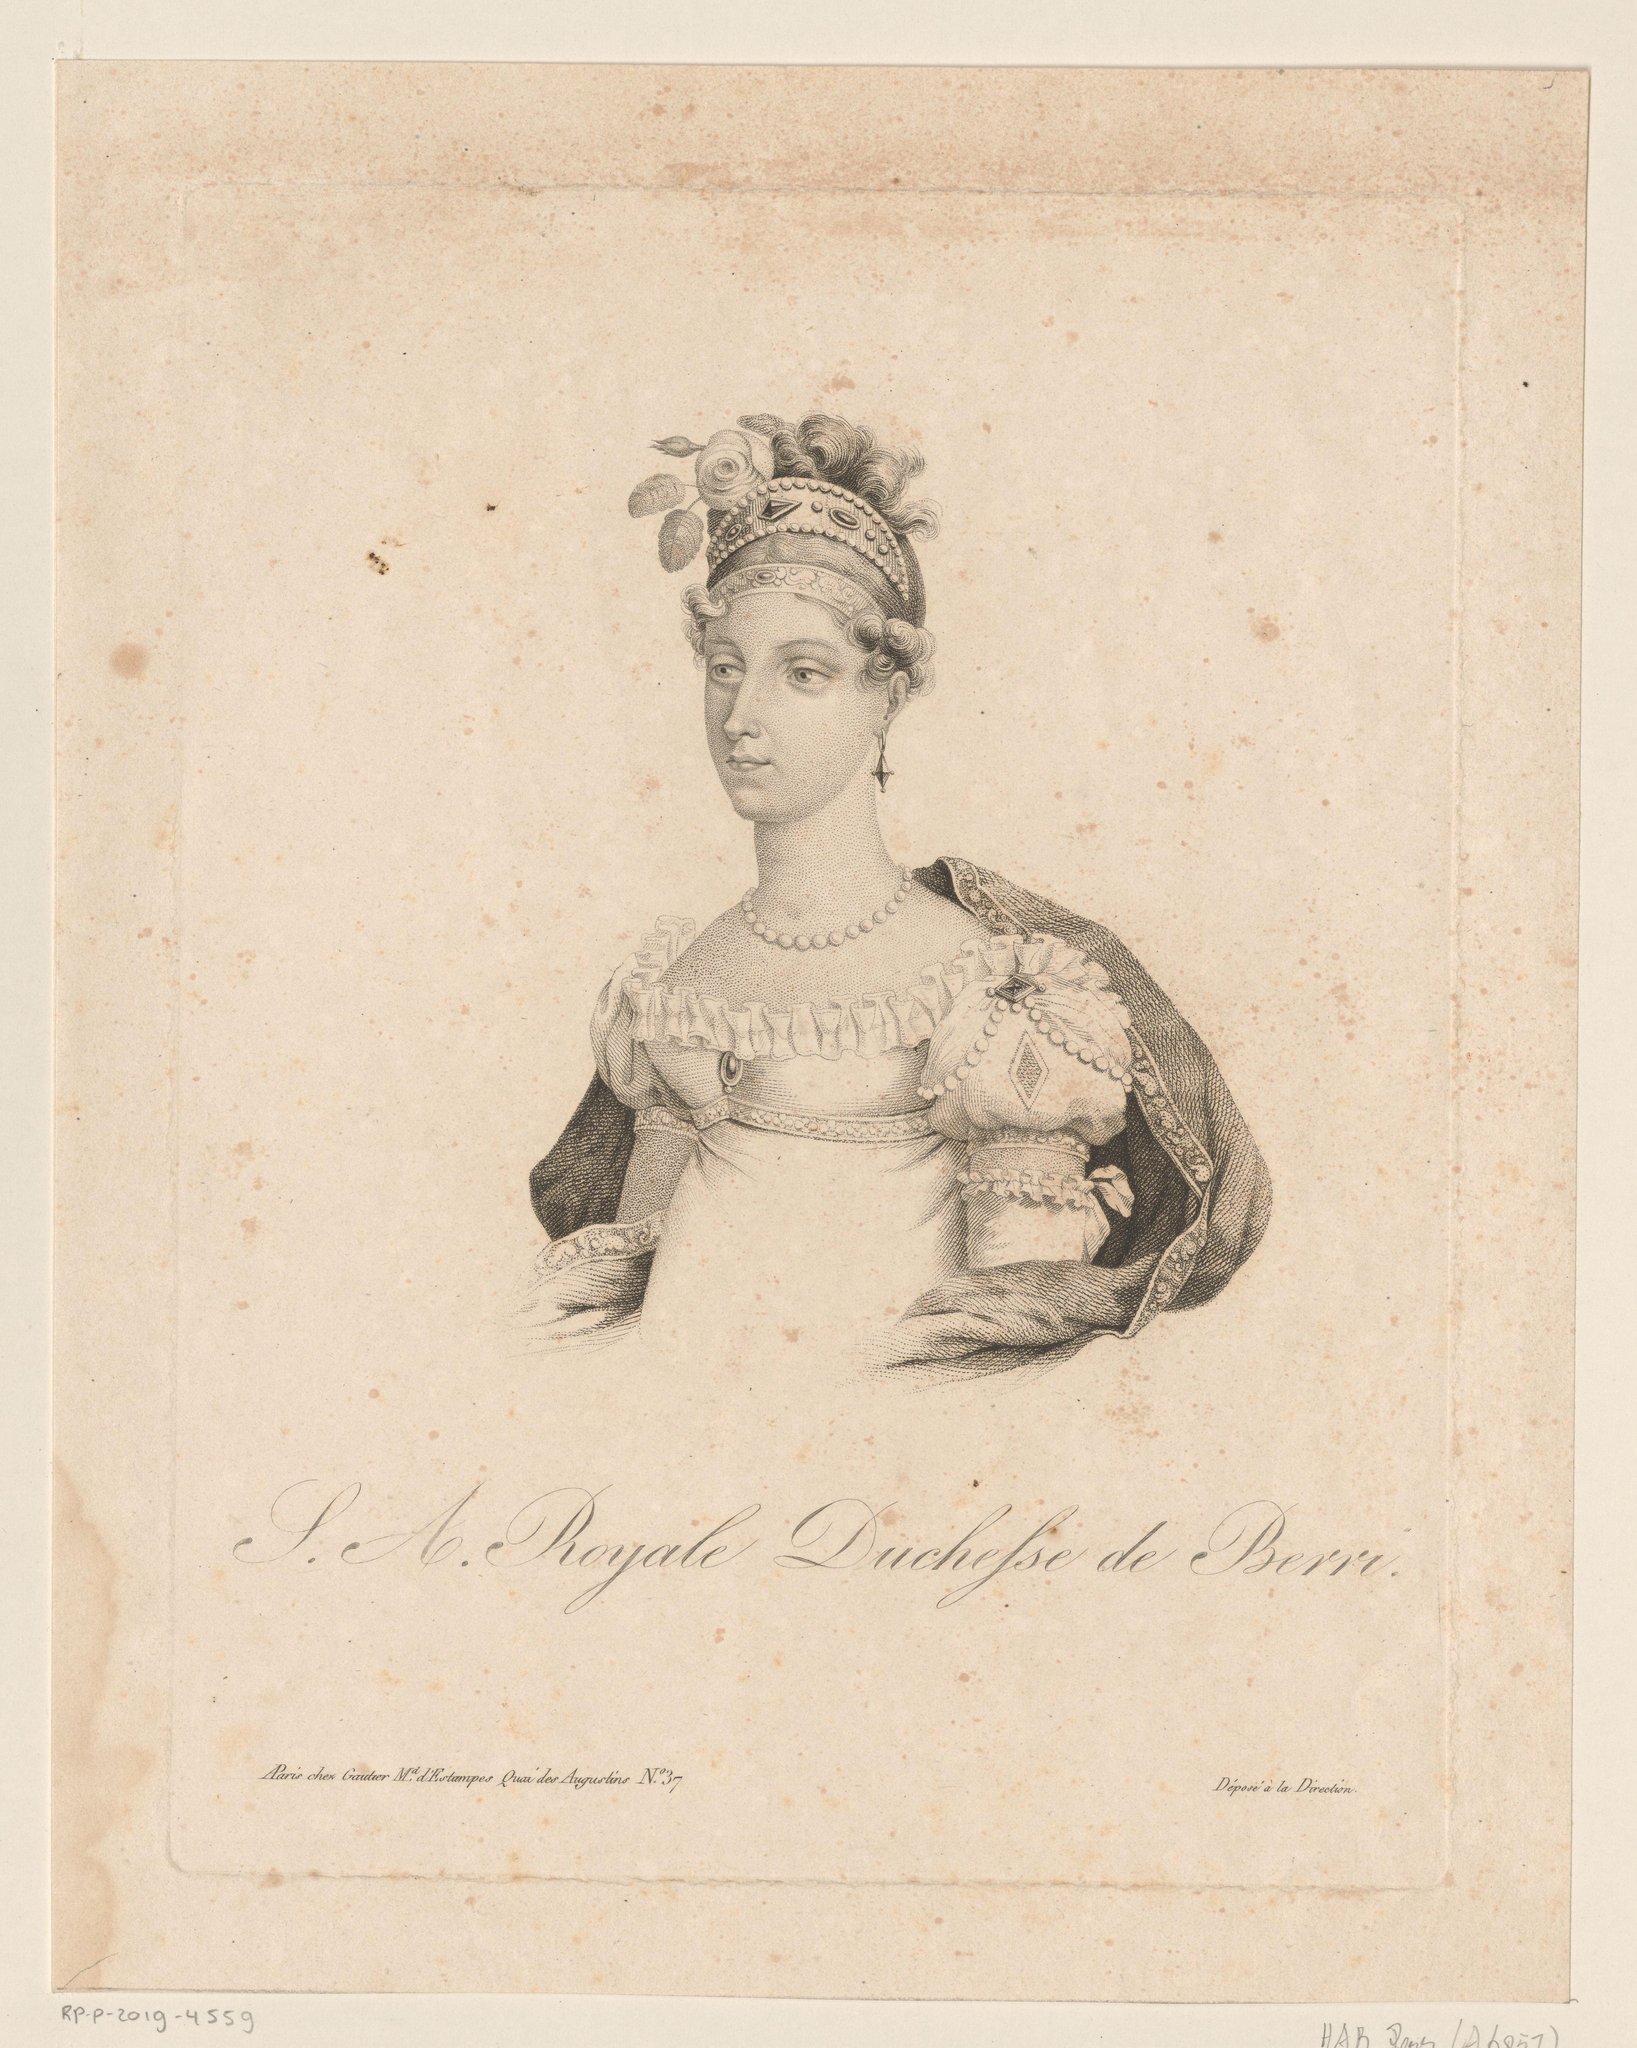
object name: print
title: Portret van Maria Carolina van Bourbon-Sicilië, hertogin van Berry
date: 1816-1849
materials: paper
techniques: engraving, etching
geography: paris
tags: maria carolina van bourbon-sicilië, historical persons - bb - woman, ornaments, jewels